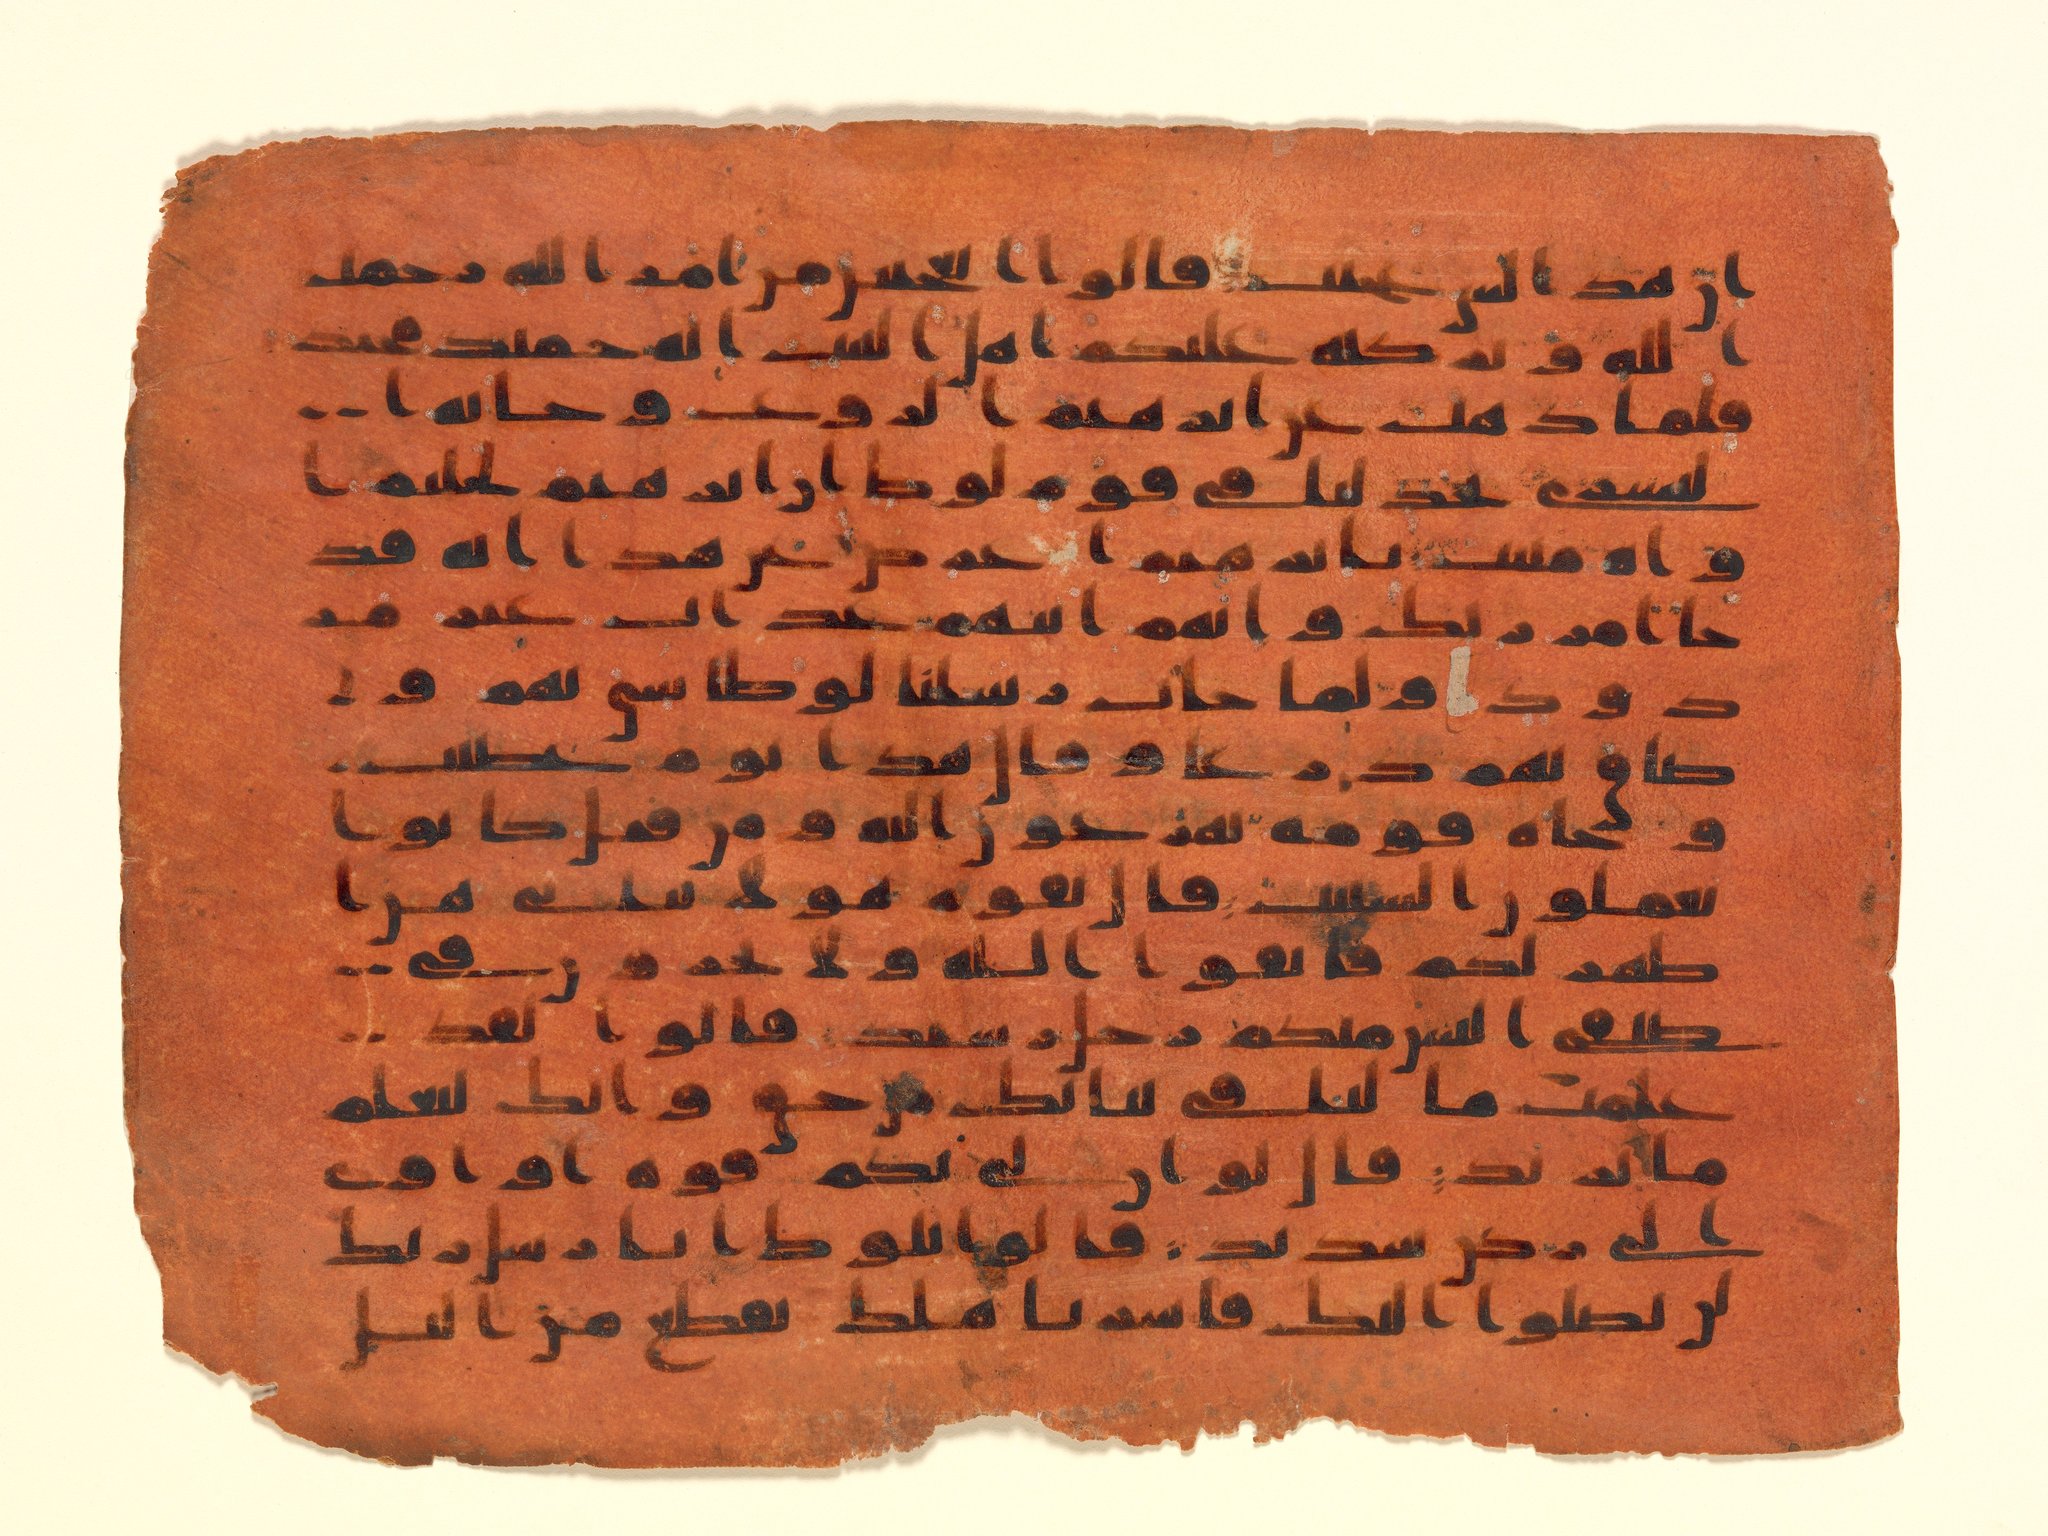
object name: folio from a non illustrated manuscript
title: Folio from a Qur'an Manuscript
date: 801-900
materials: ink, parchment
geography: central islamic lands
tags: qur'an,calligraphy